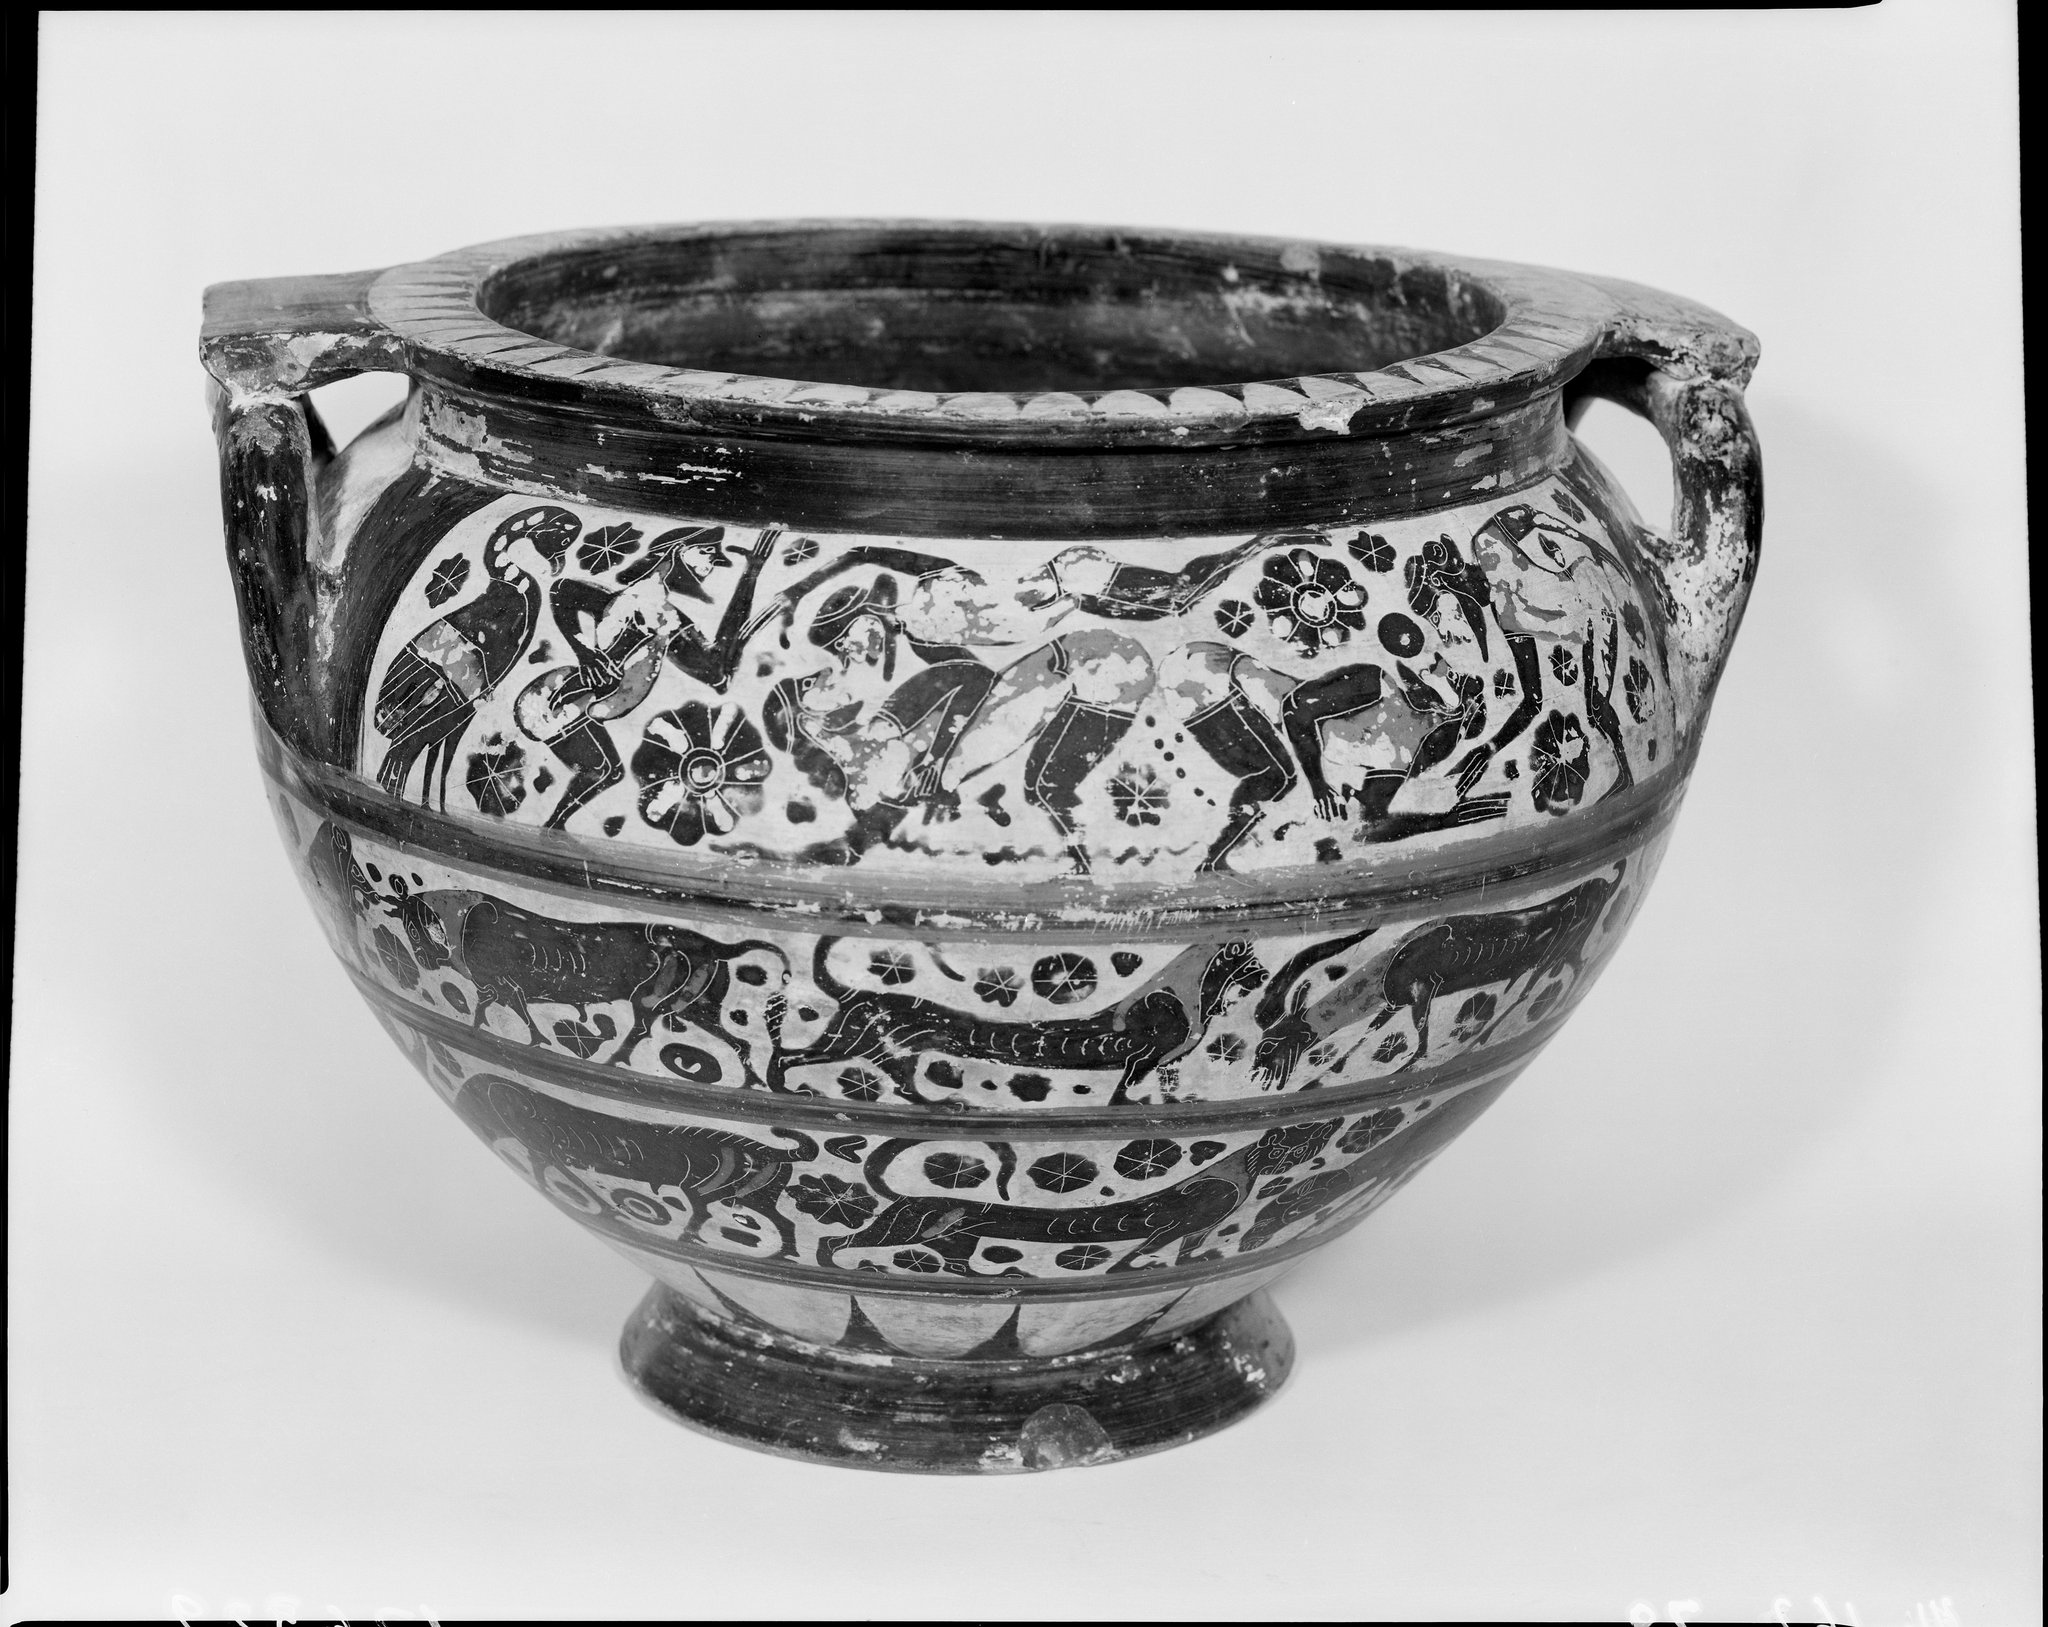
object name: column krater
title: Terracotta column-krater (bowl for mixing wine and water)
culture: greek, corinthian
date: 625-600 BCE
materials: terracotta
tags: birds,bulls,deer,lions